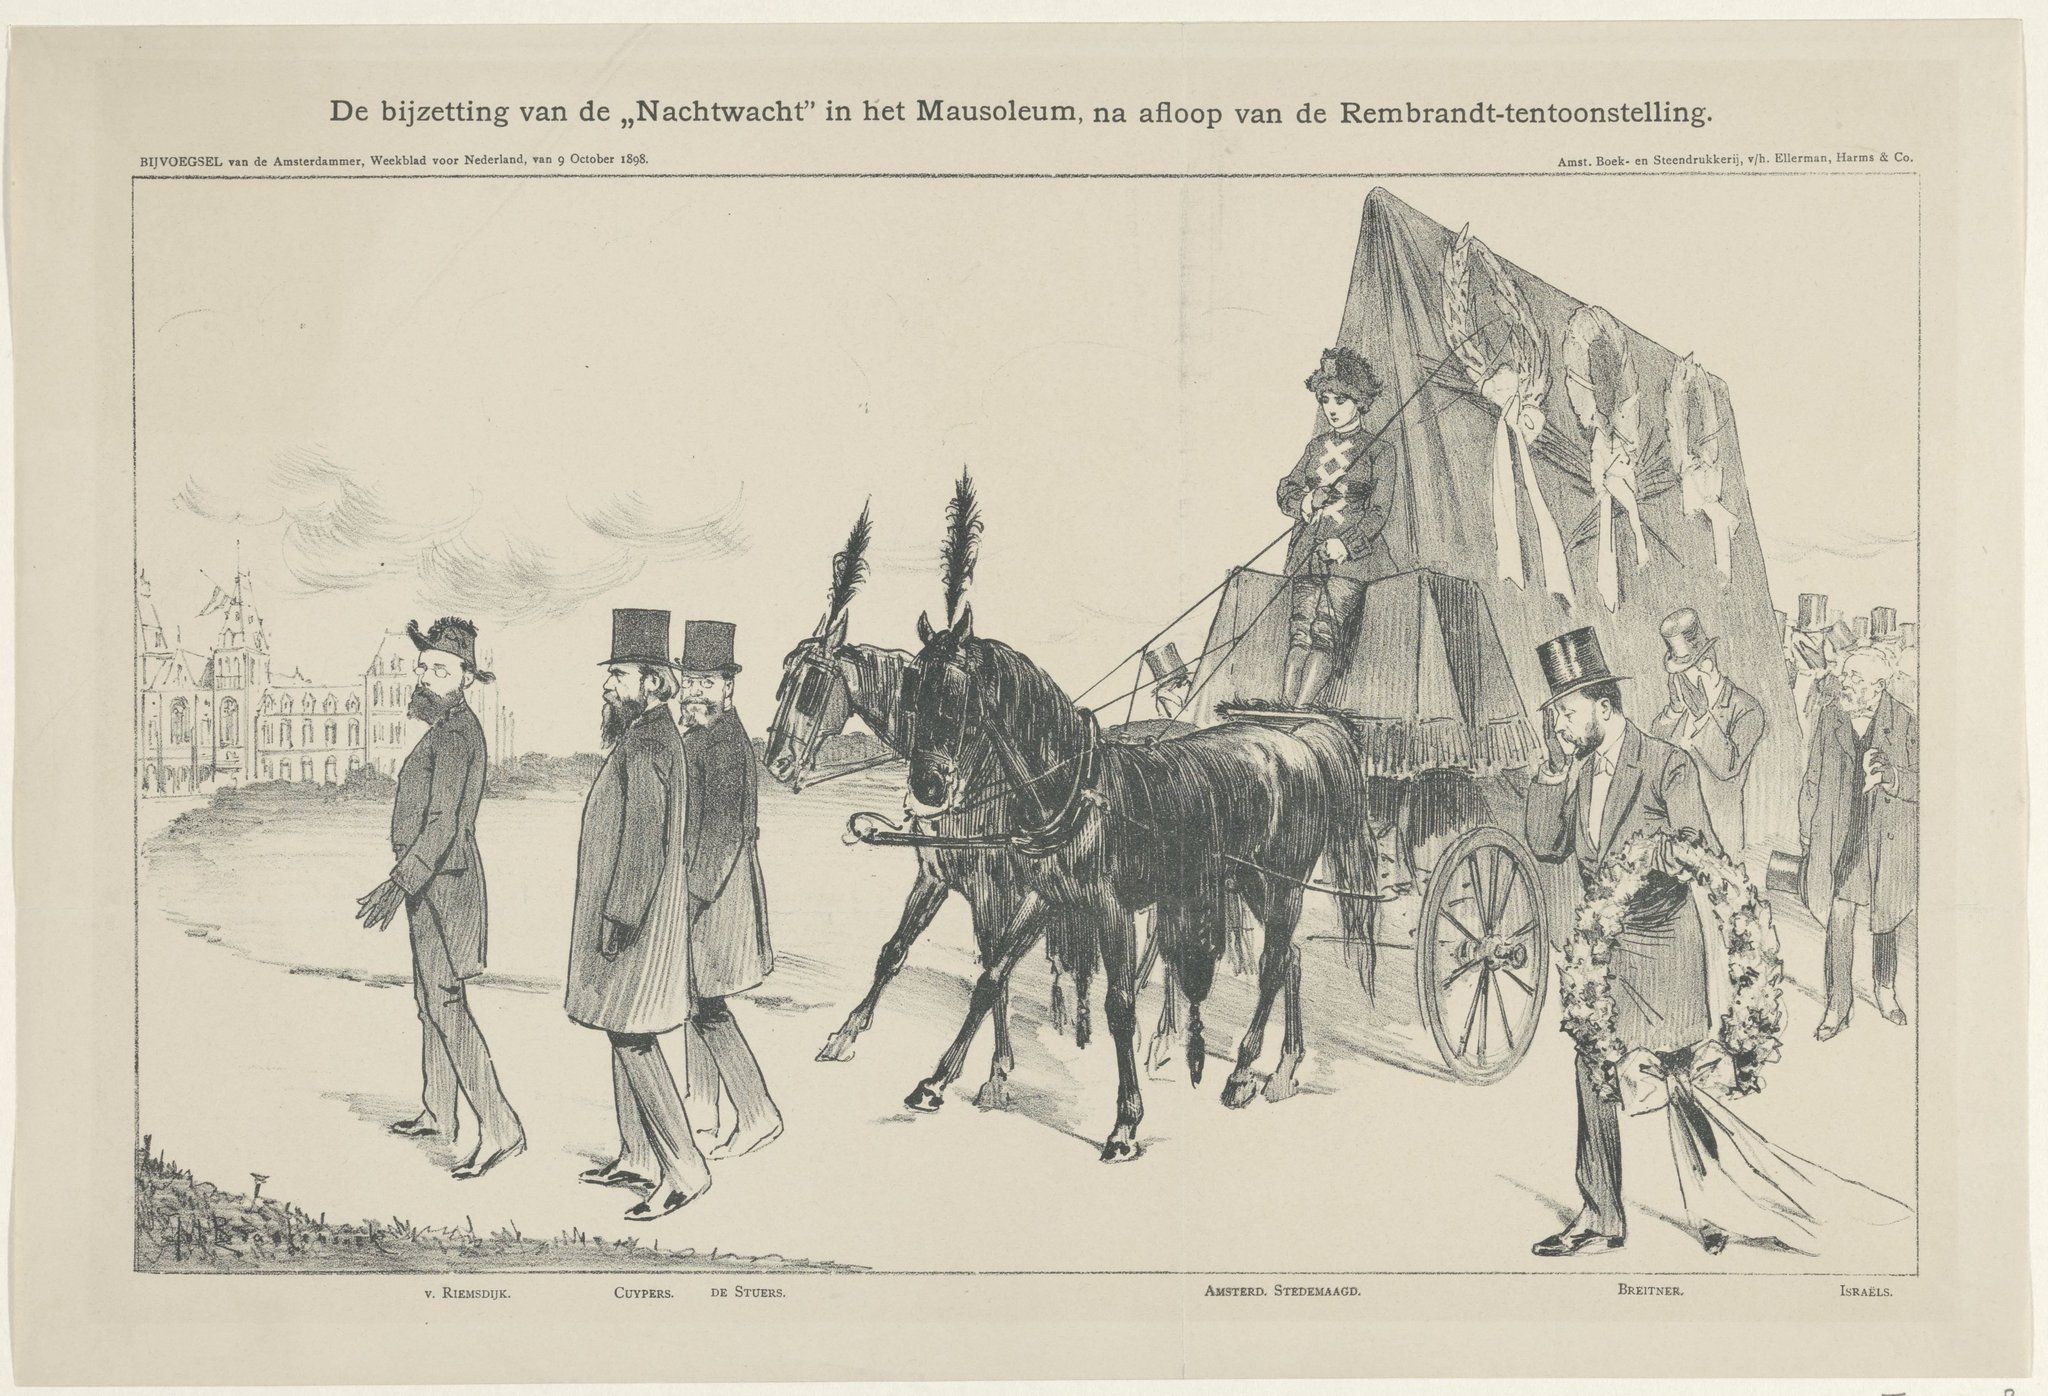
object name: cartoon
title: Spotprent op de terugkeer van Rembrandts Nachtwacht naar het Rijksmuseum, 1898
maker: johan braakensiek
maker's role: draughtsman, print maker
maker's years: 1858-1940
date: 1898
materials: paper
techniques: lithograph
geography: amsterdam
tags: george hendrik breitner, maastricht, the hague, print maker, draughtsman, jonkheer victor eugène louis de stuers, isaac israels, pierre joseph hubert cuypers, engineer, jonkheer barthold willem floris van riemsdijk, leiden, amsterdam, painter, rembrandt van rijn, rijksmuseum amsterdam, cortege, funeral procession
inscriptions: collector's mark: Lugt 2228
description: Spotprent op de terugkeer van Rembrandts schilderij de Nachtwacht naar het Rijksmuseum na afloop van de Rembrandt tentoonstelling in het Stedelijk Museum te Amsterdam in 1898. Het ingepakte schilderij wordt op een lijkwagen naar het Rijksmuseum gereden als in een begrafenisstoet. Voor de wagen lopen Van Riemsdijk, Pierre Cuypers en Victor de Stuers, rechts naast de wagen Breitner en Israëls. Uitgegeven als bijvoegsel van de Amsterdammer, Weekblad voor Nederland, van 9 oktober 1898.